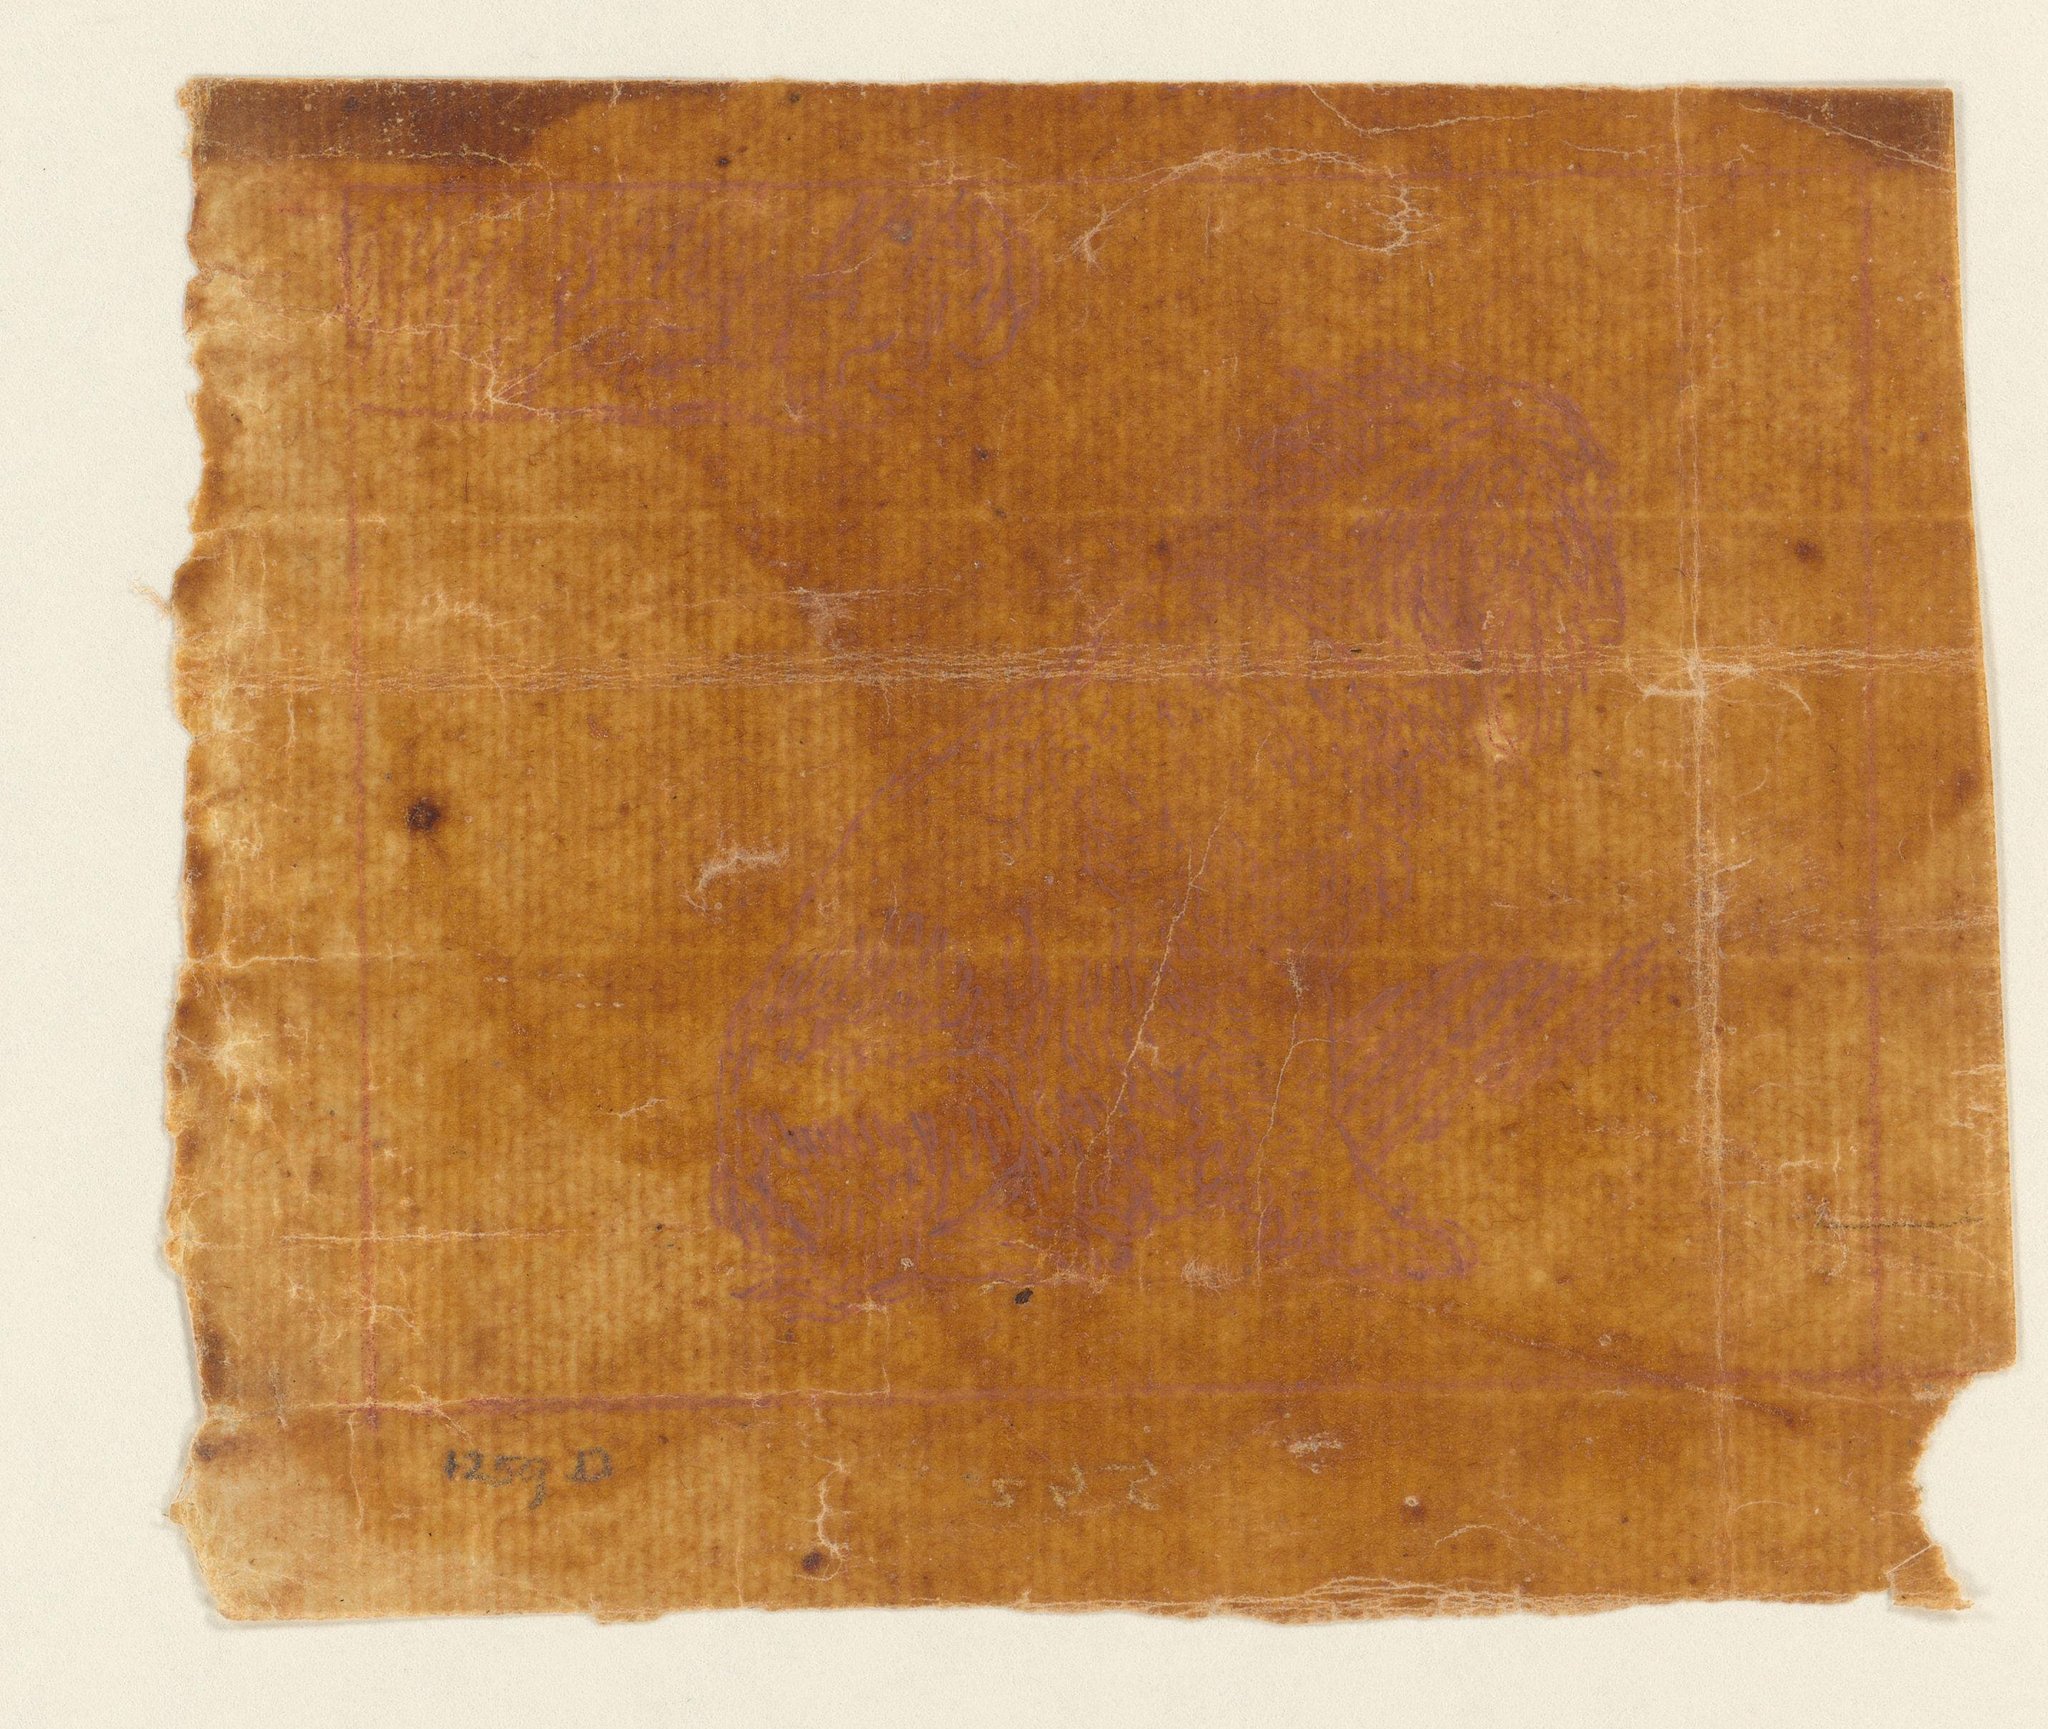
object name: tracing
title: Zittende hond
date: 1777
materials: chalk, paper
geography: amsterdam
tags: dog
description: Over de calques van Ploos van Amstel zie LNP, p. 201.